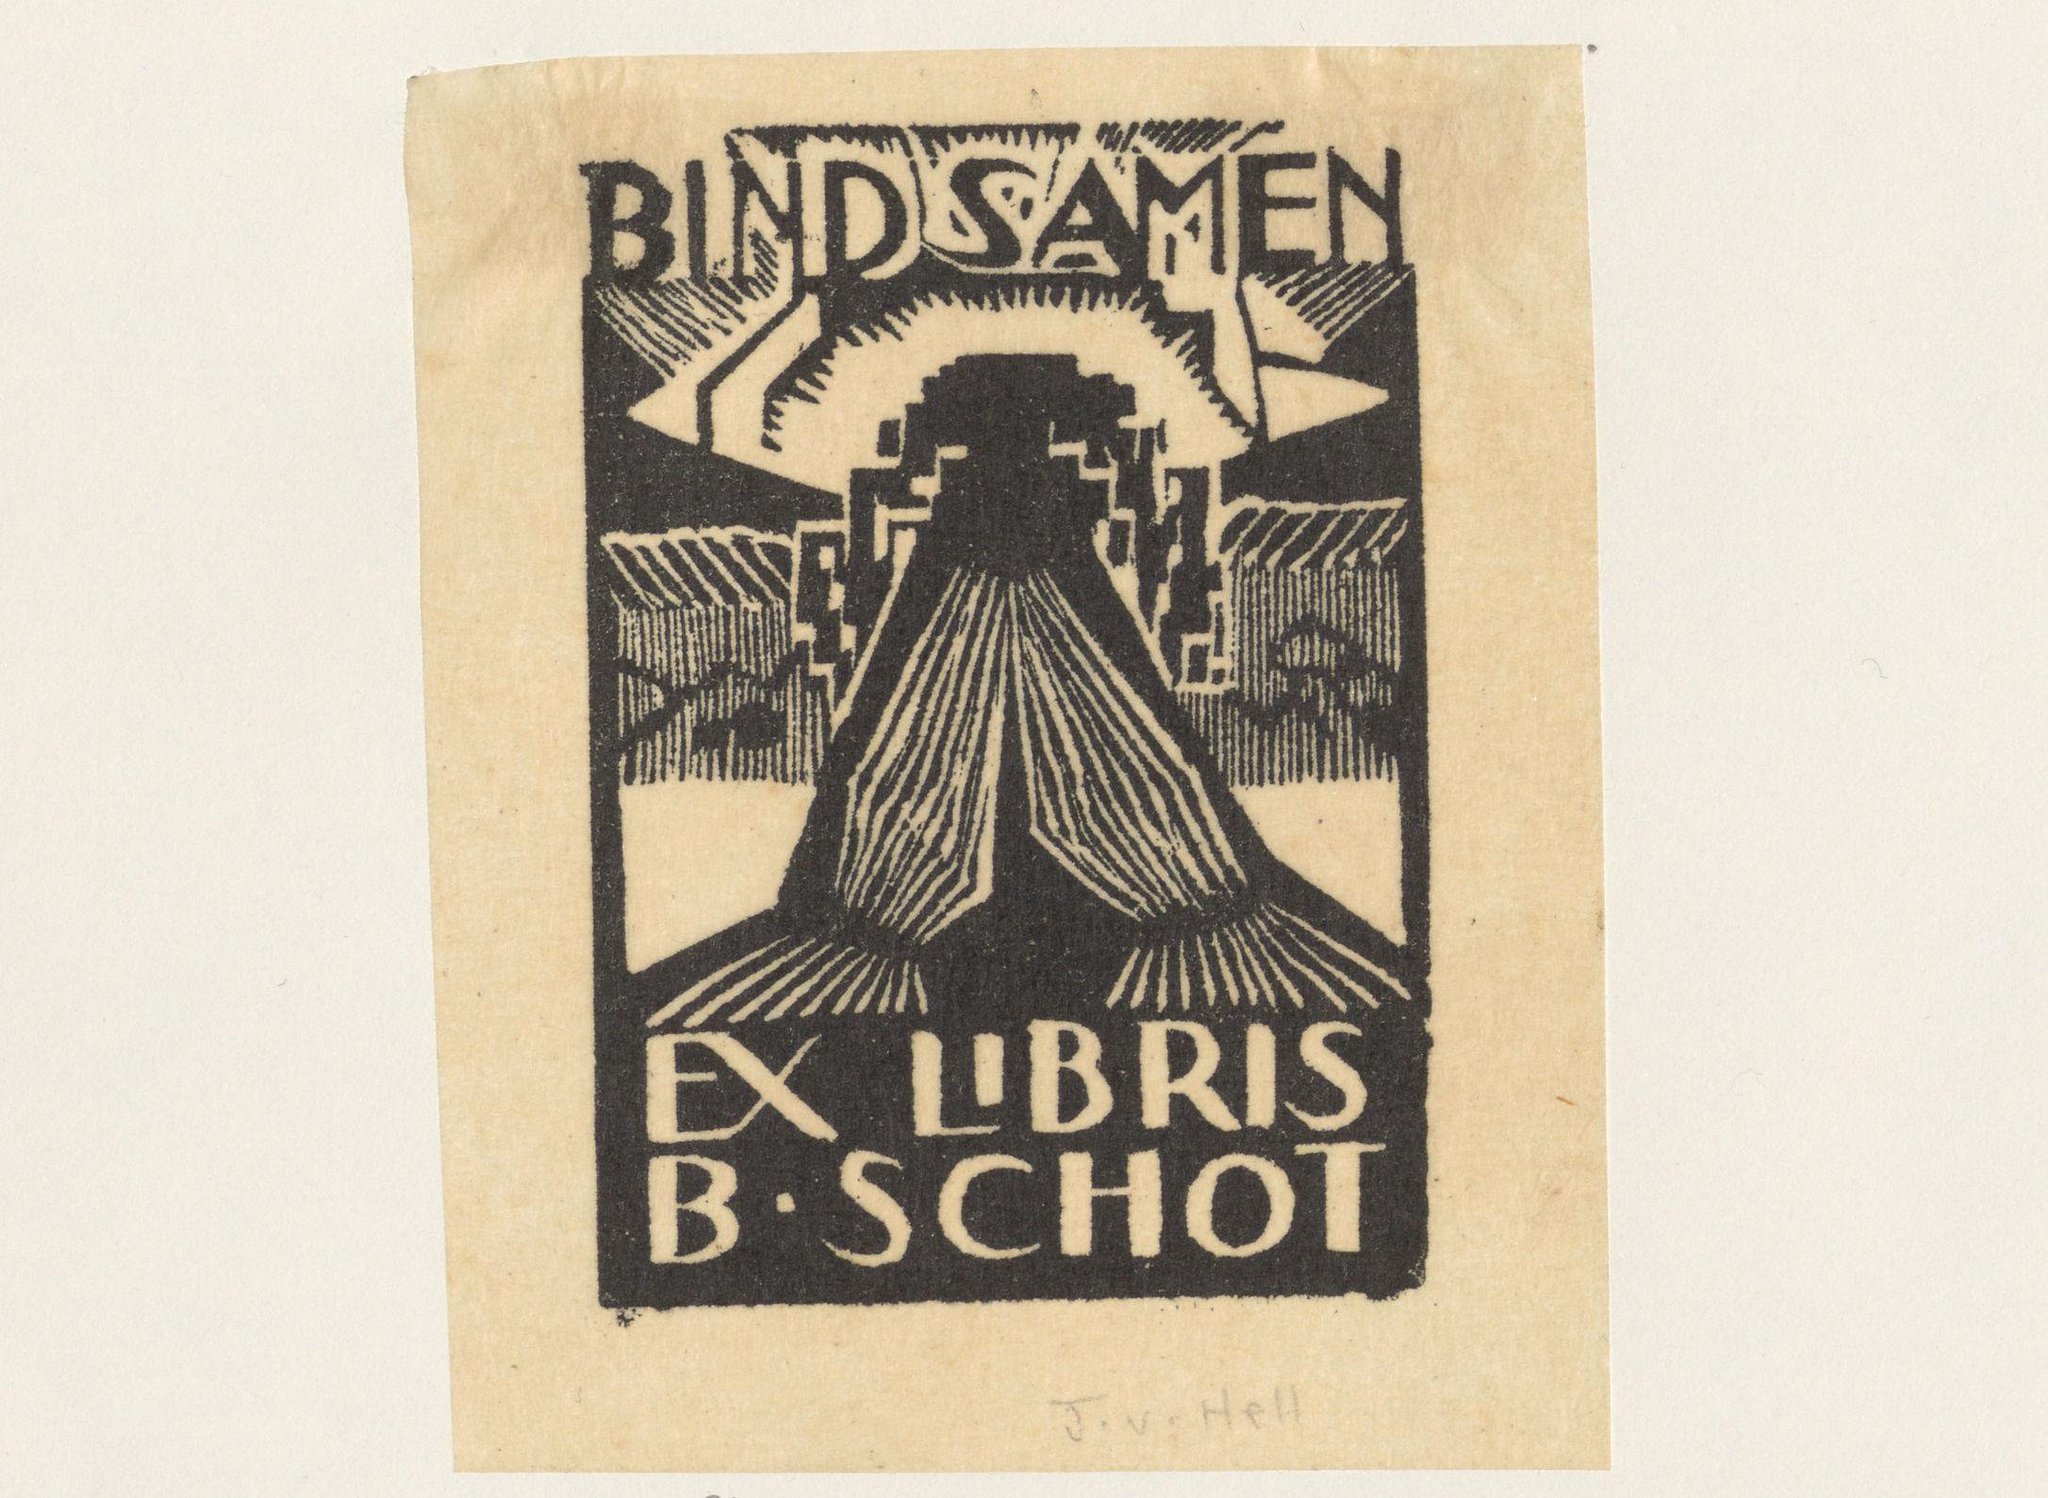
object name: bookplate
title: Ex libris van B. Schot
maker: johan van hell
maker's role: print maker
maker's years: 1889-1952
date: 1923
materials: paper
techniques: woodcut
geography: netherlands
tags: vineyard